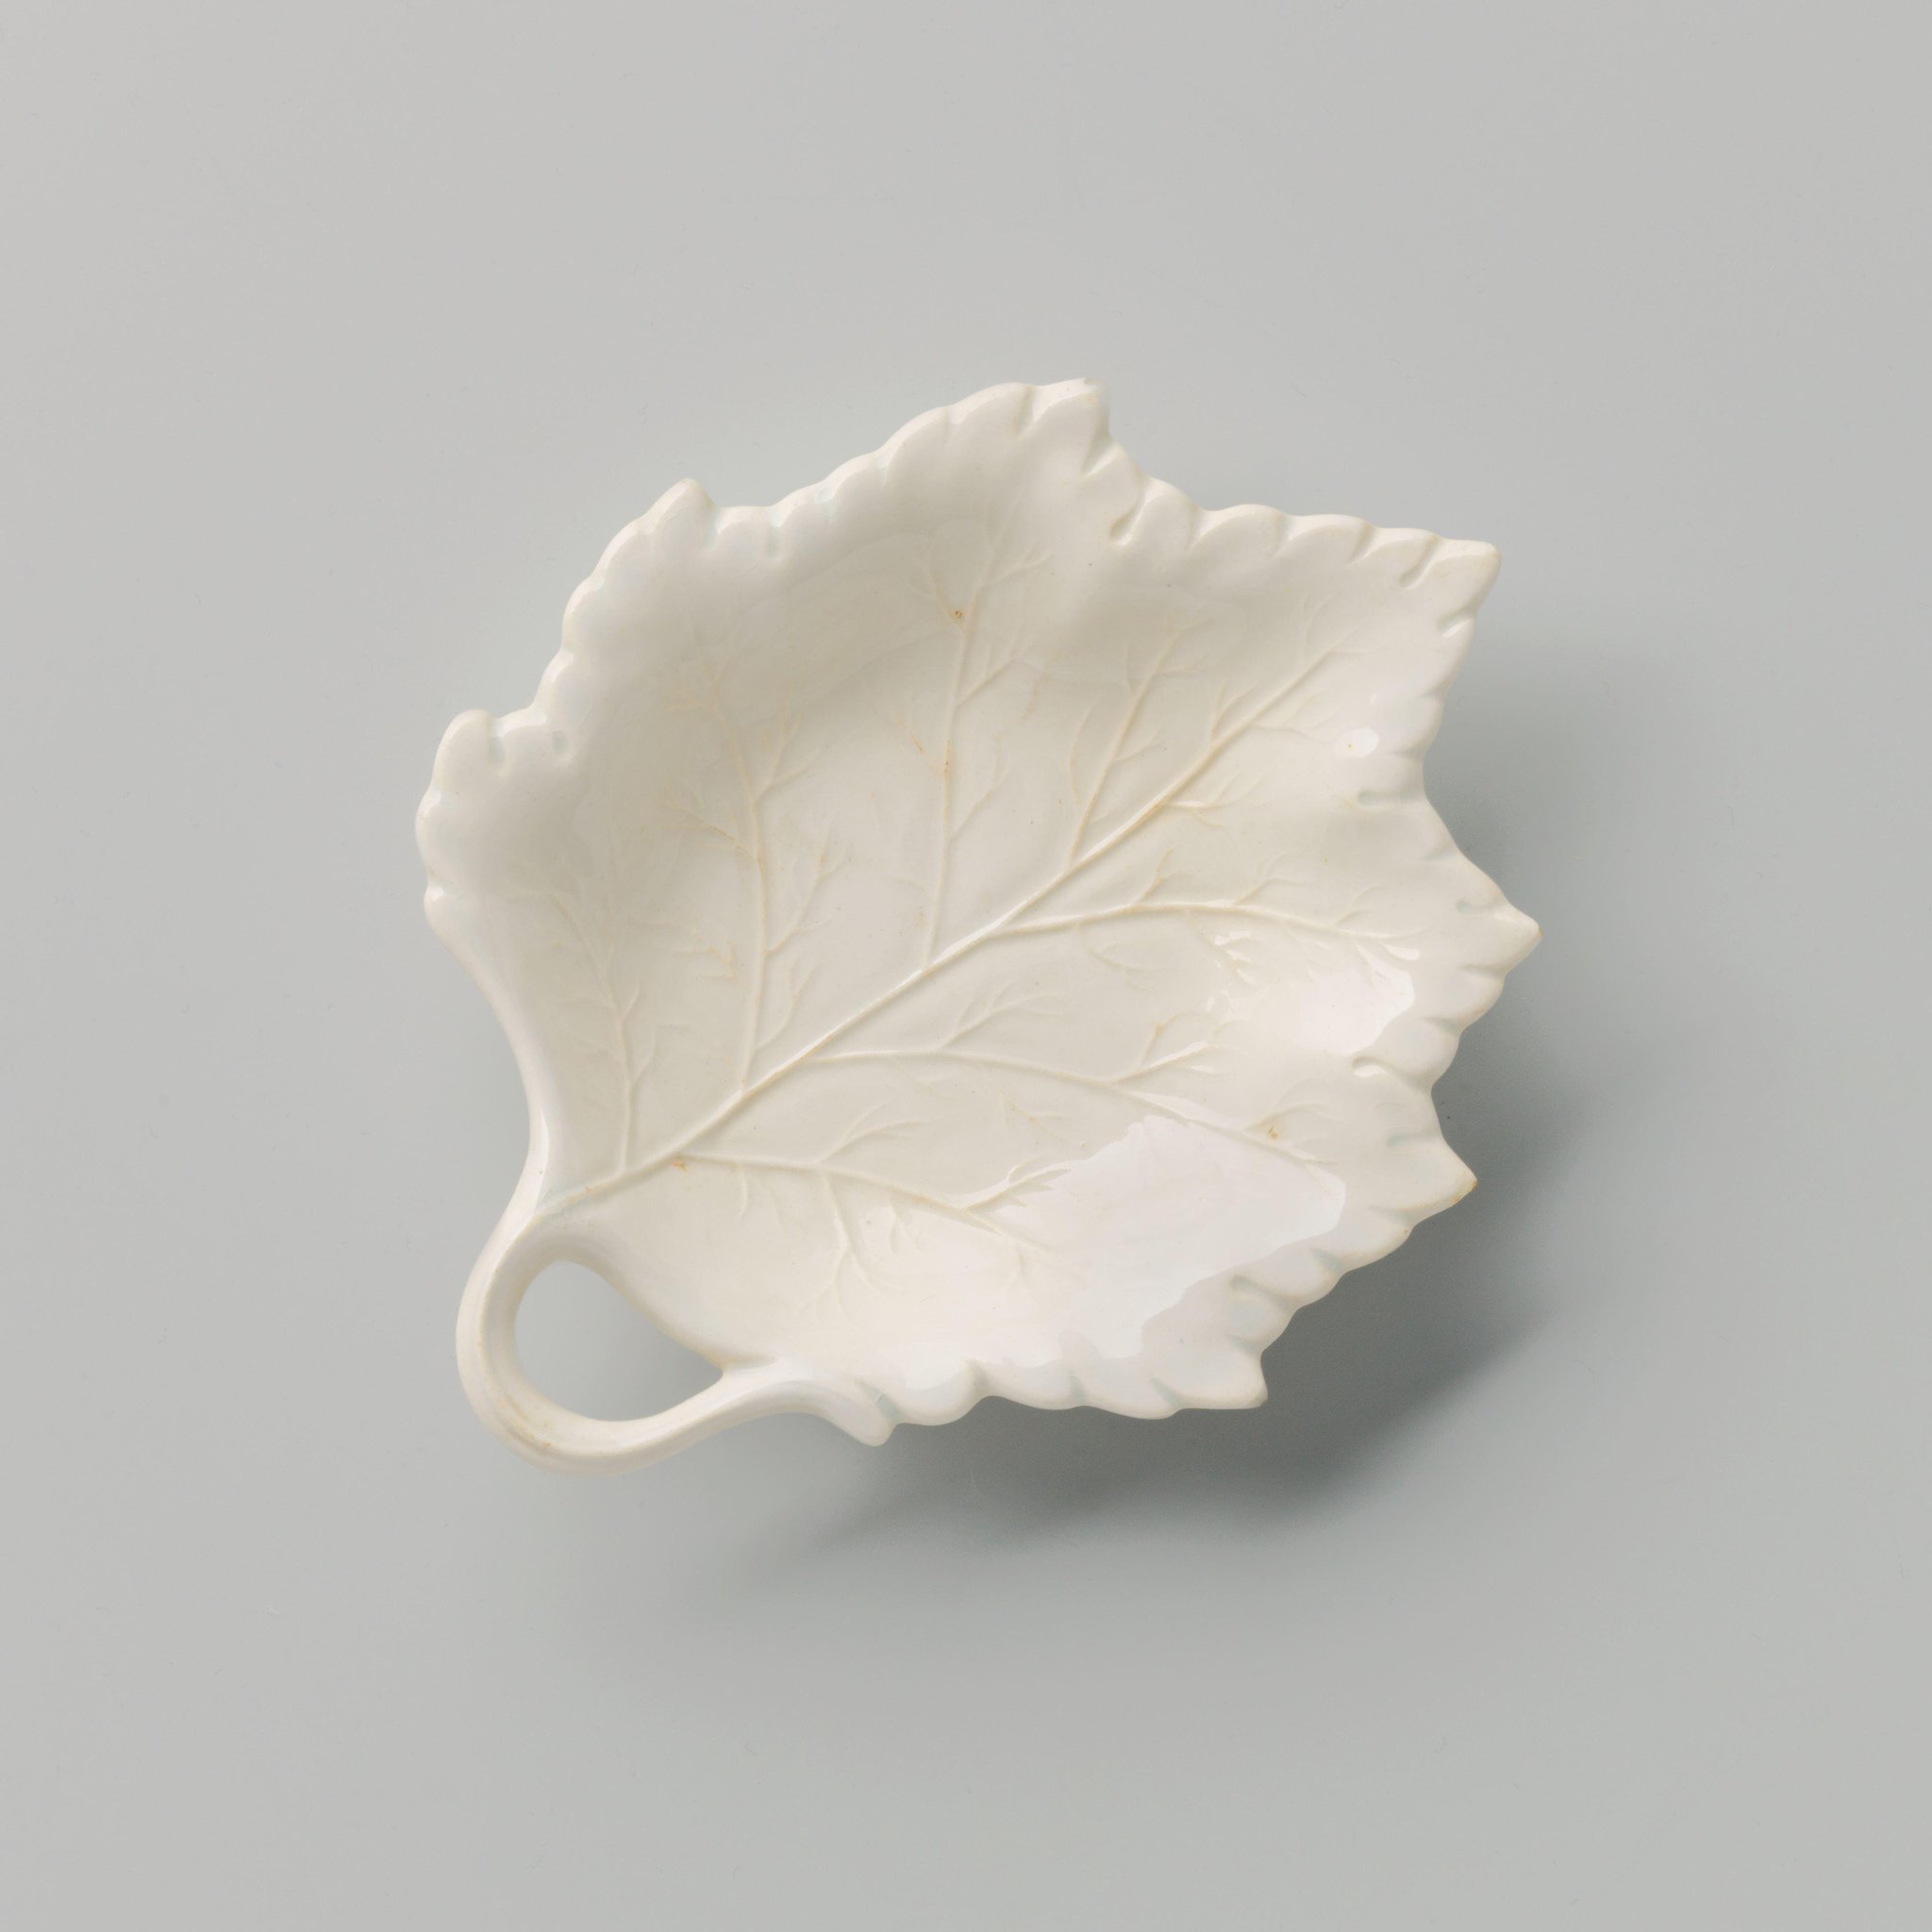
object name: dish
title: Dessertschaal in de vorm van een druivenblad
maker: petrus regout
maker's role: plateelbakker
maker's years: 1801-1879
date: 1860-1890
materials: creamware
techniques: vitrification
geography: maastricht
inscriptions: check stamp: ‘P. REGOUT // 14 // MAASTRICHT’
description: Dessertschaal van witgeglazuurd aardewerk, in reliëf uitgevoerd in de vorm van een druivenblad.